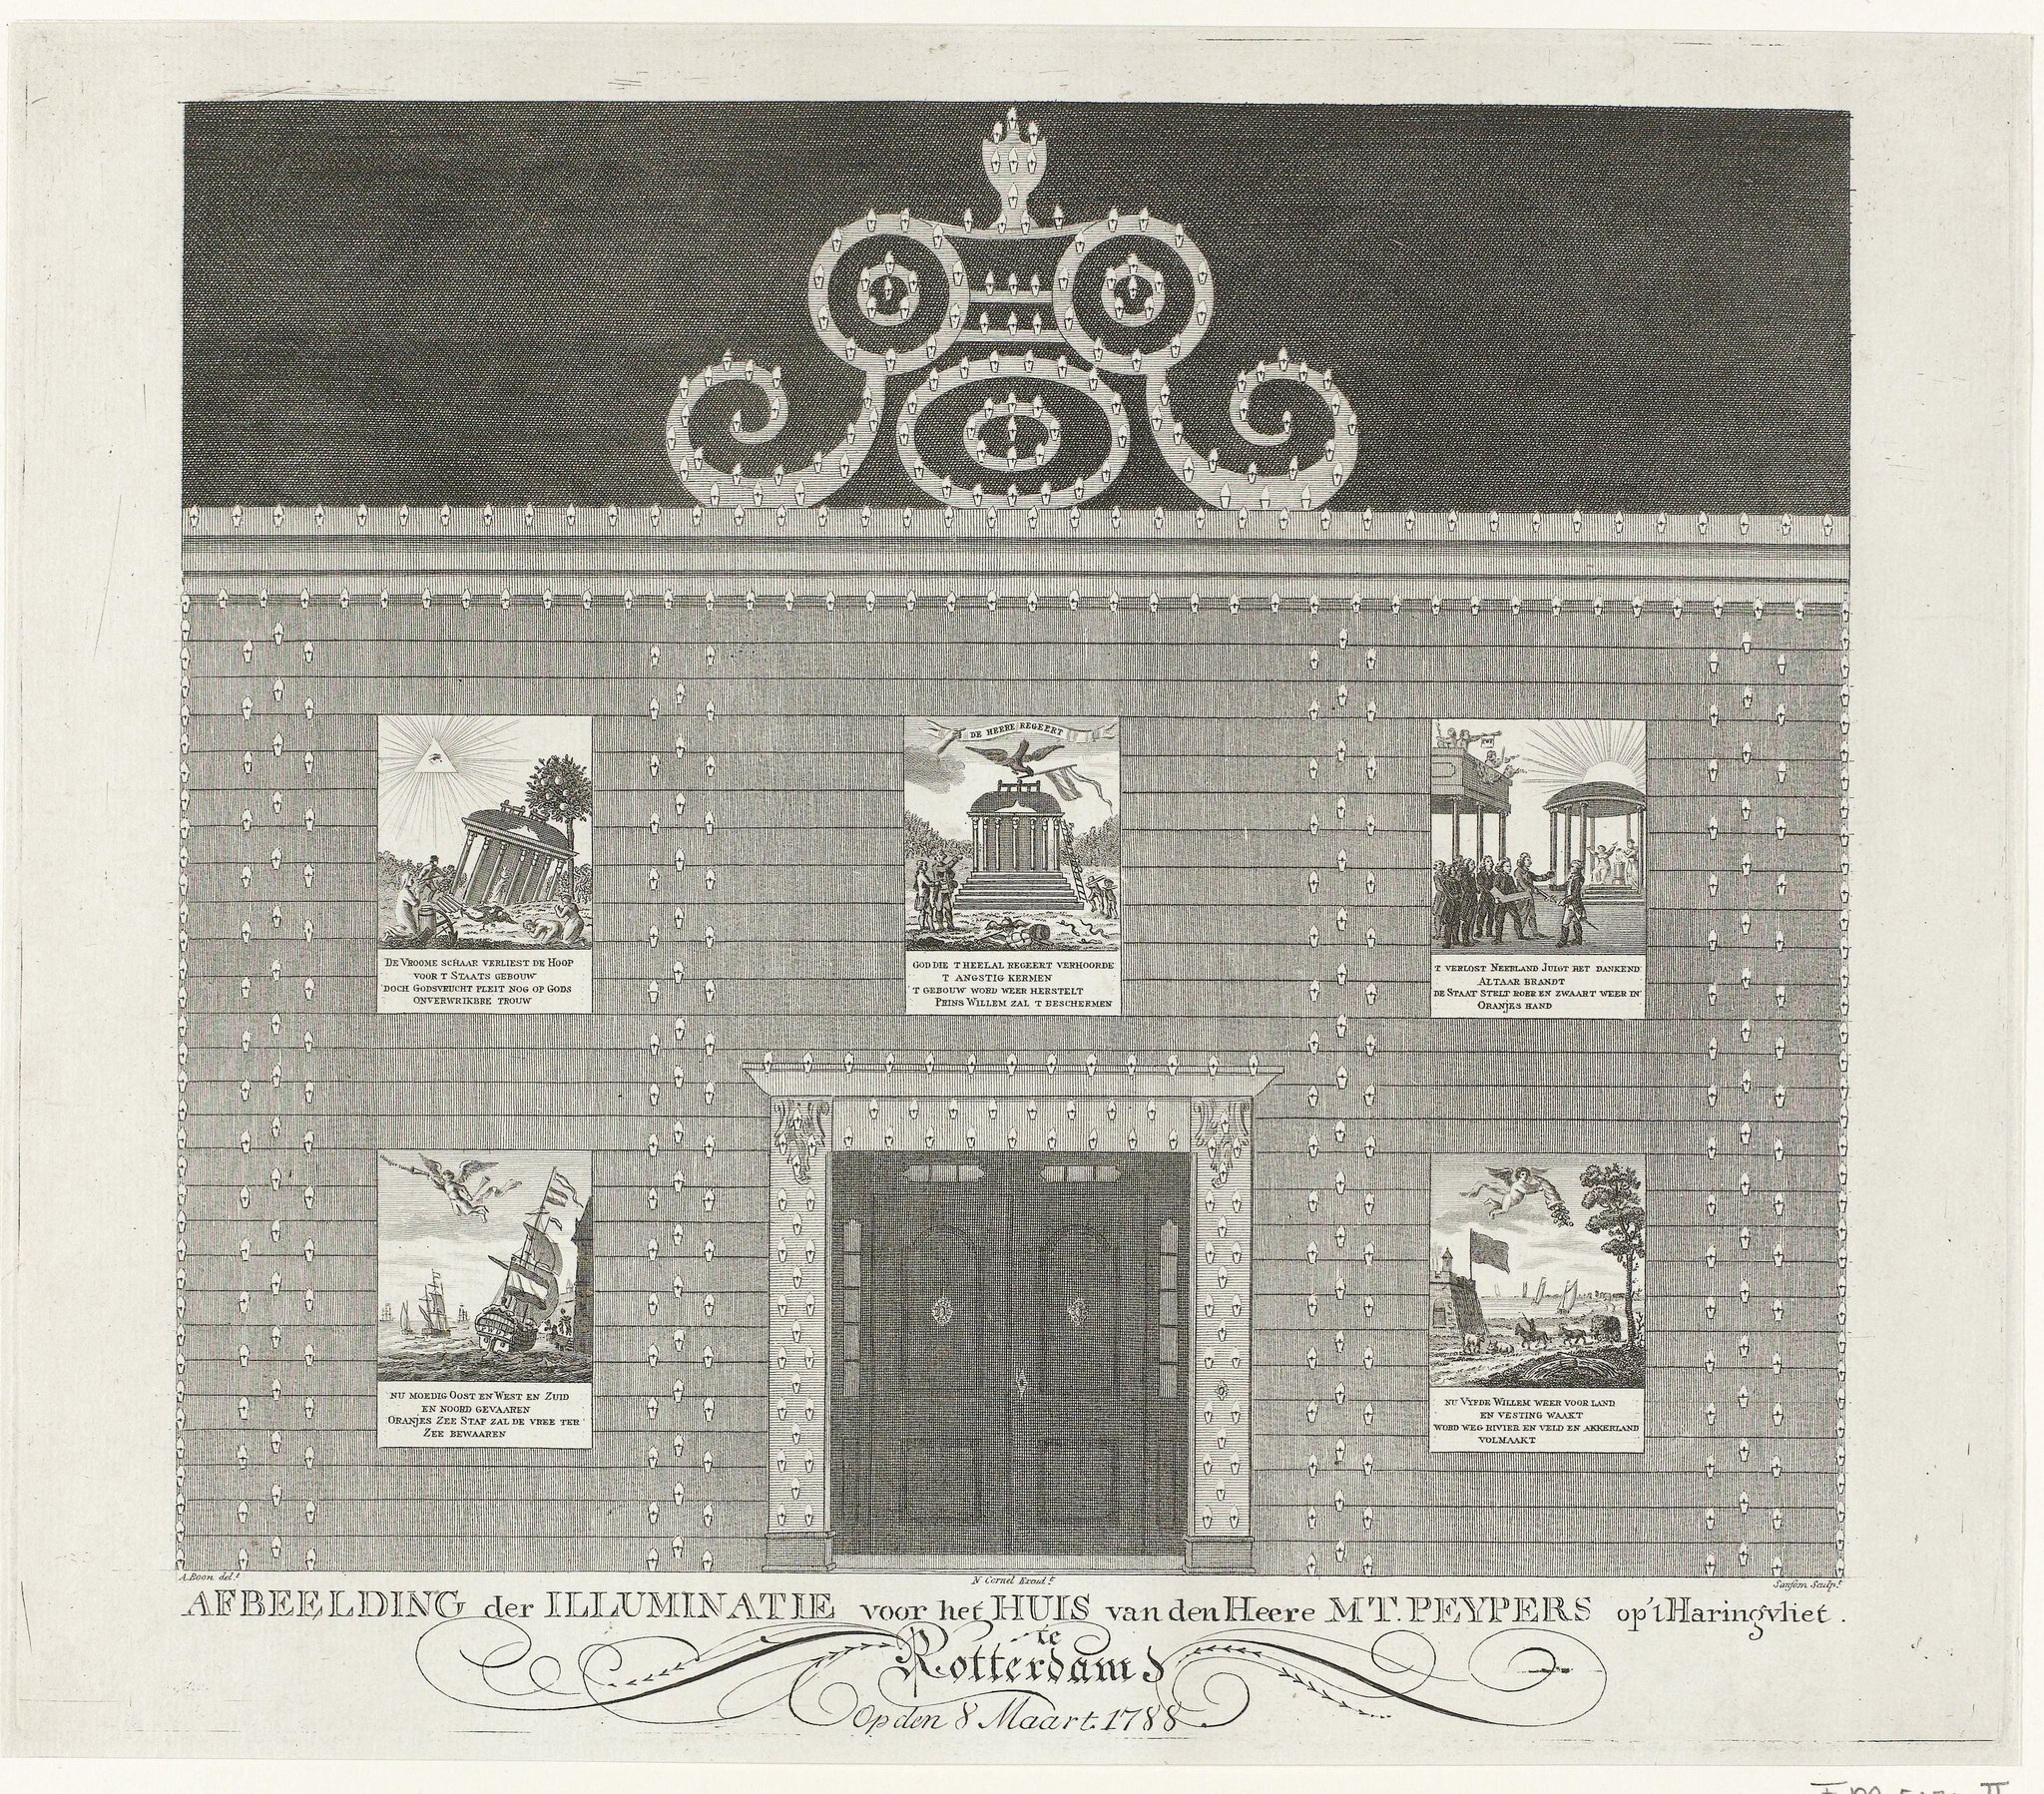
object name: print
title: Afbeelding der Illuminatie voor het Huis van den Heere M.T. Peypers op 't Haringvliet te Rotterdam Op den 8 Maart 1788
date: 1788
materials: paper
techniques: engraving, etching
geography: rotterdam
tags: william v (prince of orange), rotterdam, bonfire, fire-works (+ illumination, fire-works ~ festive activities)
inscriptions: collector's mark: Lugt 2228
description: Illuminatie van de gevel van het huis van Matthias Theodorus Peypers aan het Haringvliet te Rotterdam, ter gelegenheid van de veertigste verjaardag van prins Willem V op 8 maart 1788. Op de gevel vijf chassinetten met allegorische voorstellingen.